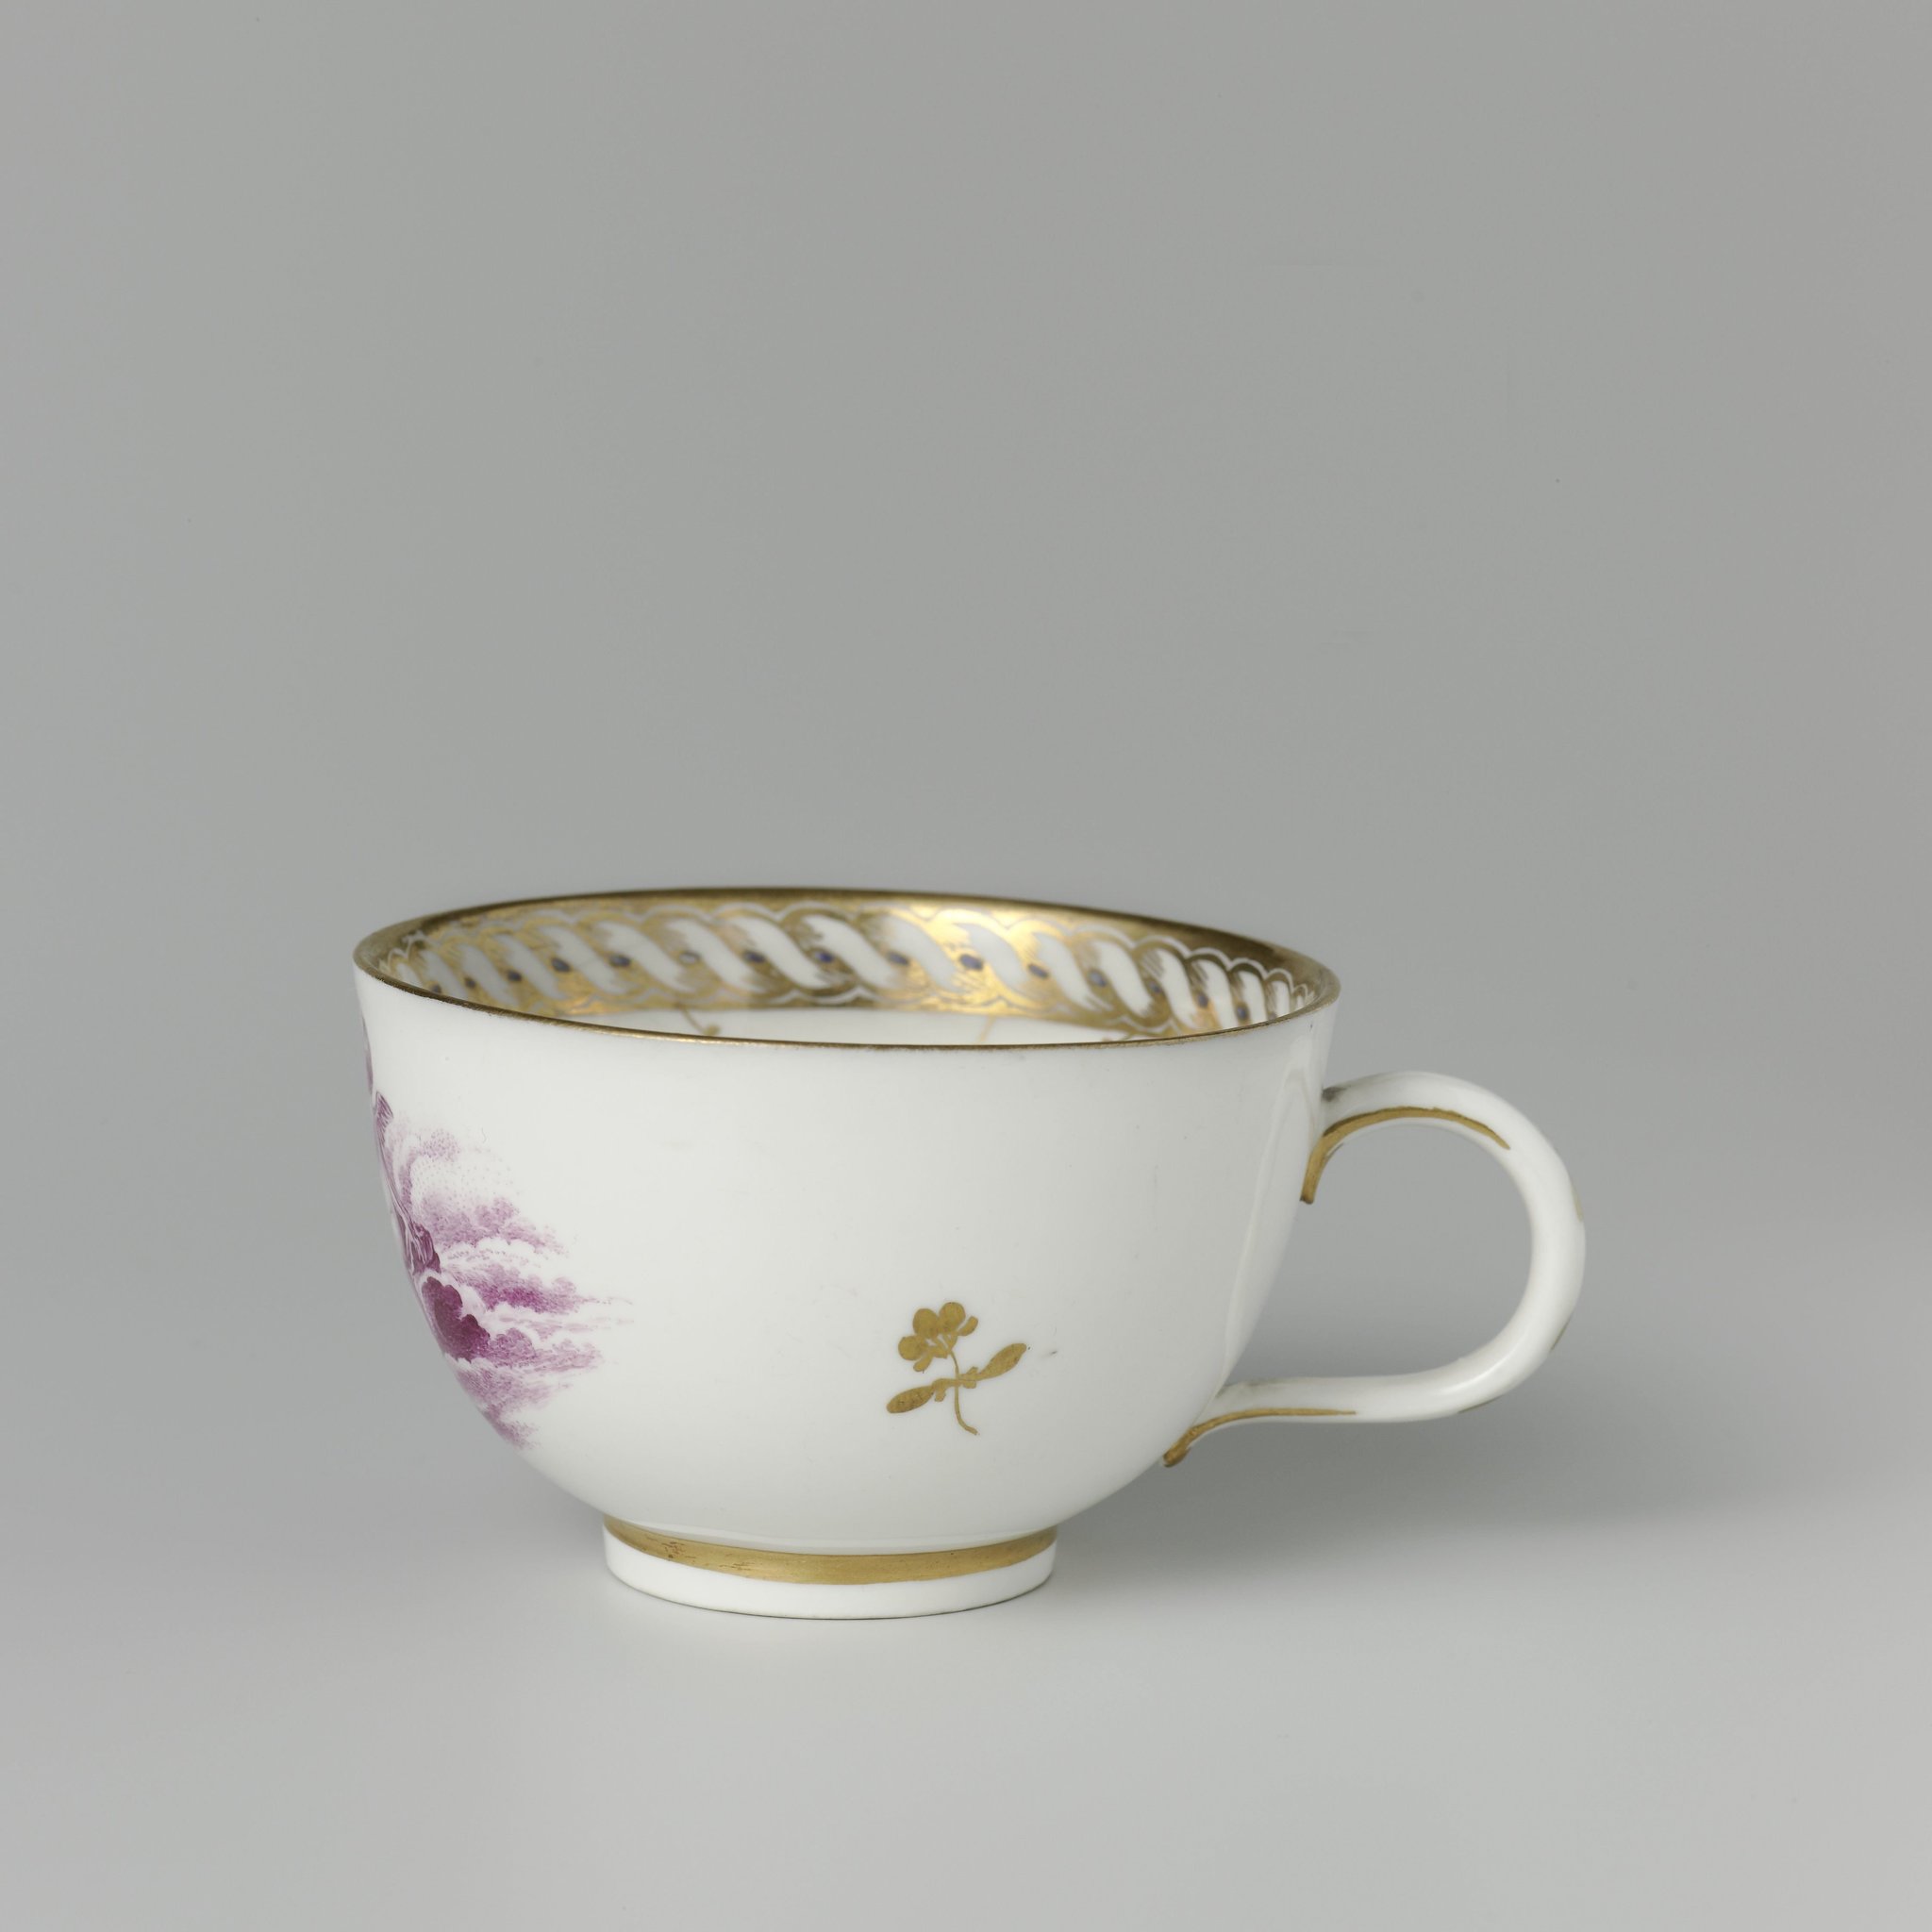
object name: service set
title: Cup with putti on clouds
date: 1785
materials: glaze, gold, paint, porcelain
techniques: firing, forming, gilding, turning, vitrification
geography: the hague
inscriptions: mark: ‘ooievaar’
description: Kop (theekop) van porselein met een C-vormig oor, beschilderd op het glazuur in roze (camaïeu) en goud. Op de buitenwand twee putti op een wolk. Om de voorstelling strooibloemen in goud. De binnenrand met een gedraaide band, waaraan guirlandes en bloemtakken hangen. Gouden lijn op de voet en gouden rand. Gemerkt op de onderzijde met de ooievaar.